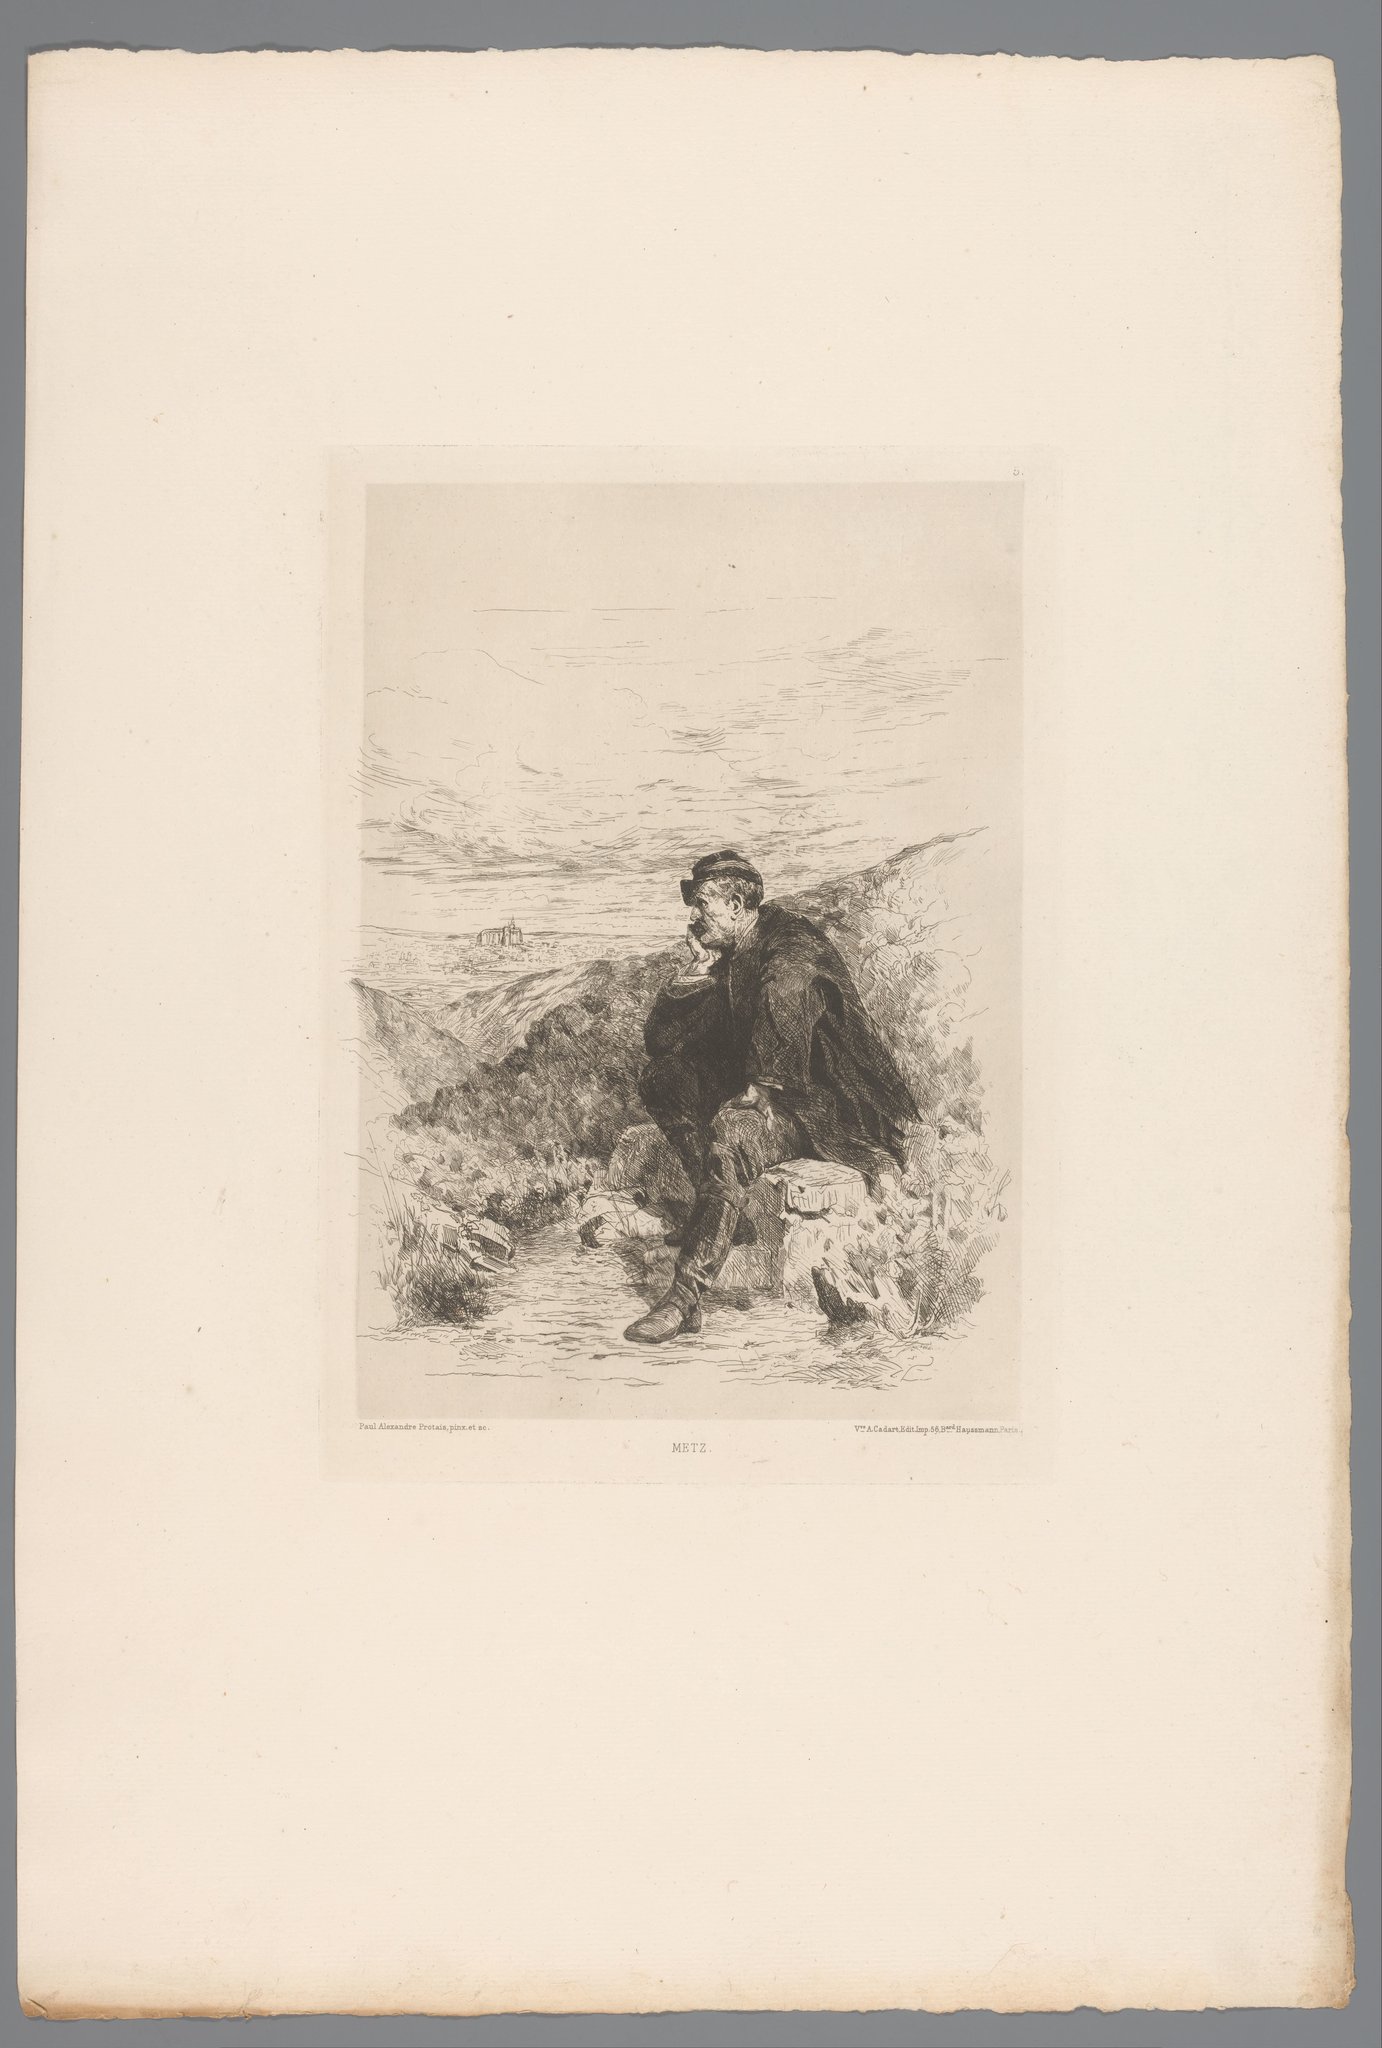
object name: print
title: L'eau-forte en 1877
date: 1877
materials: paper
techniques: drypoint, etching, intaglio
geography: paris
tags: sitting figure, landscapes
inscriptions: collector's mark: Lugt 2760, collector's mark: ‘AFE v S’, collector's mark: Lugt 2228